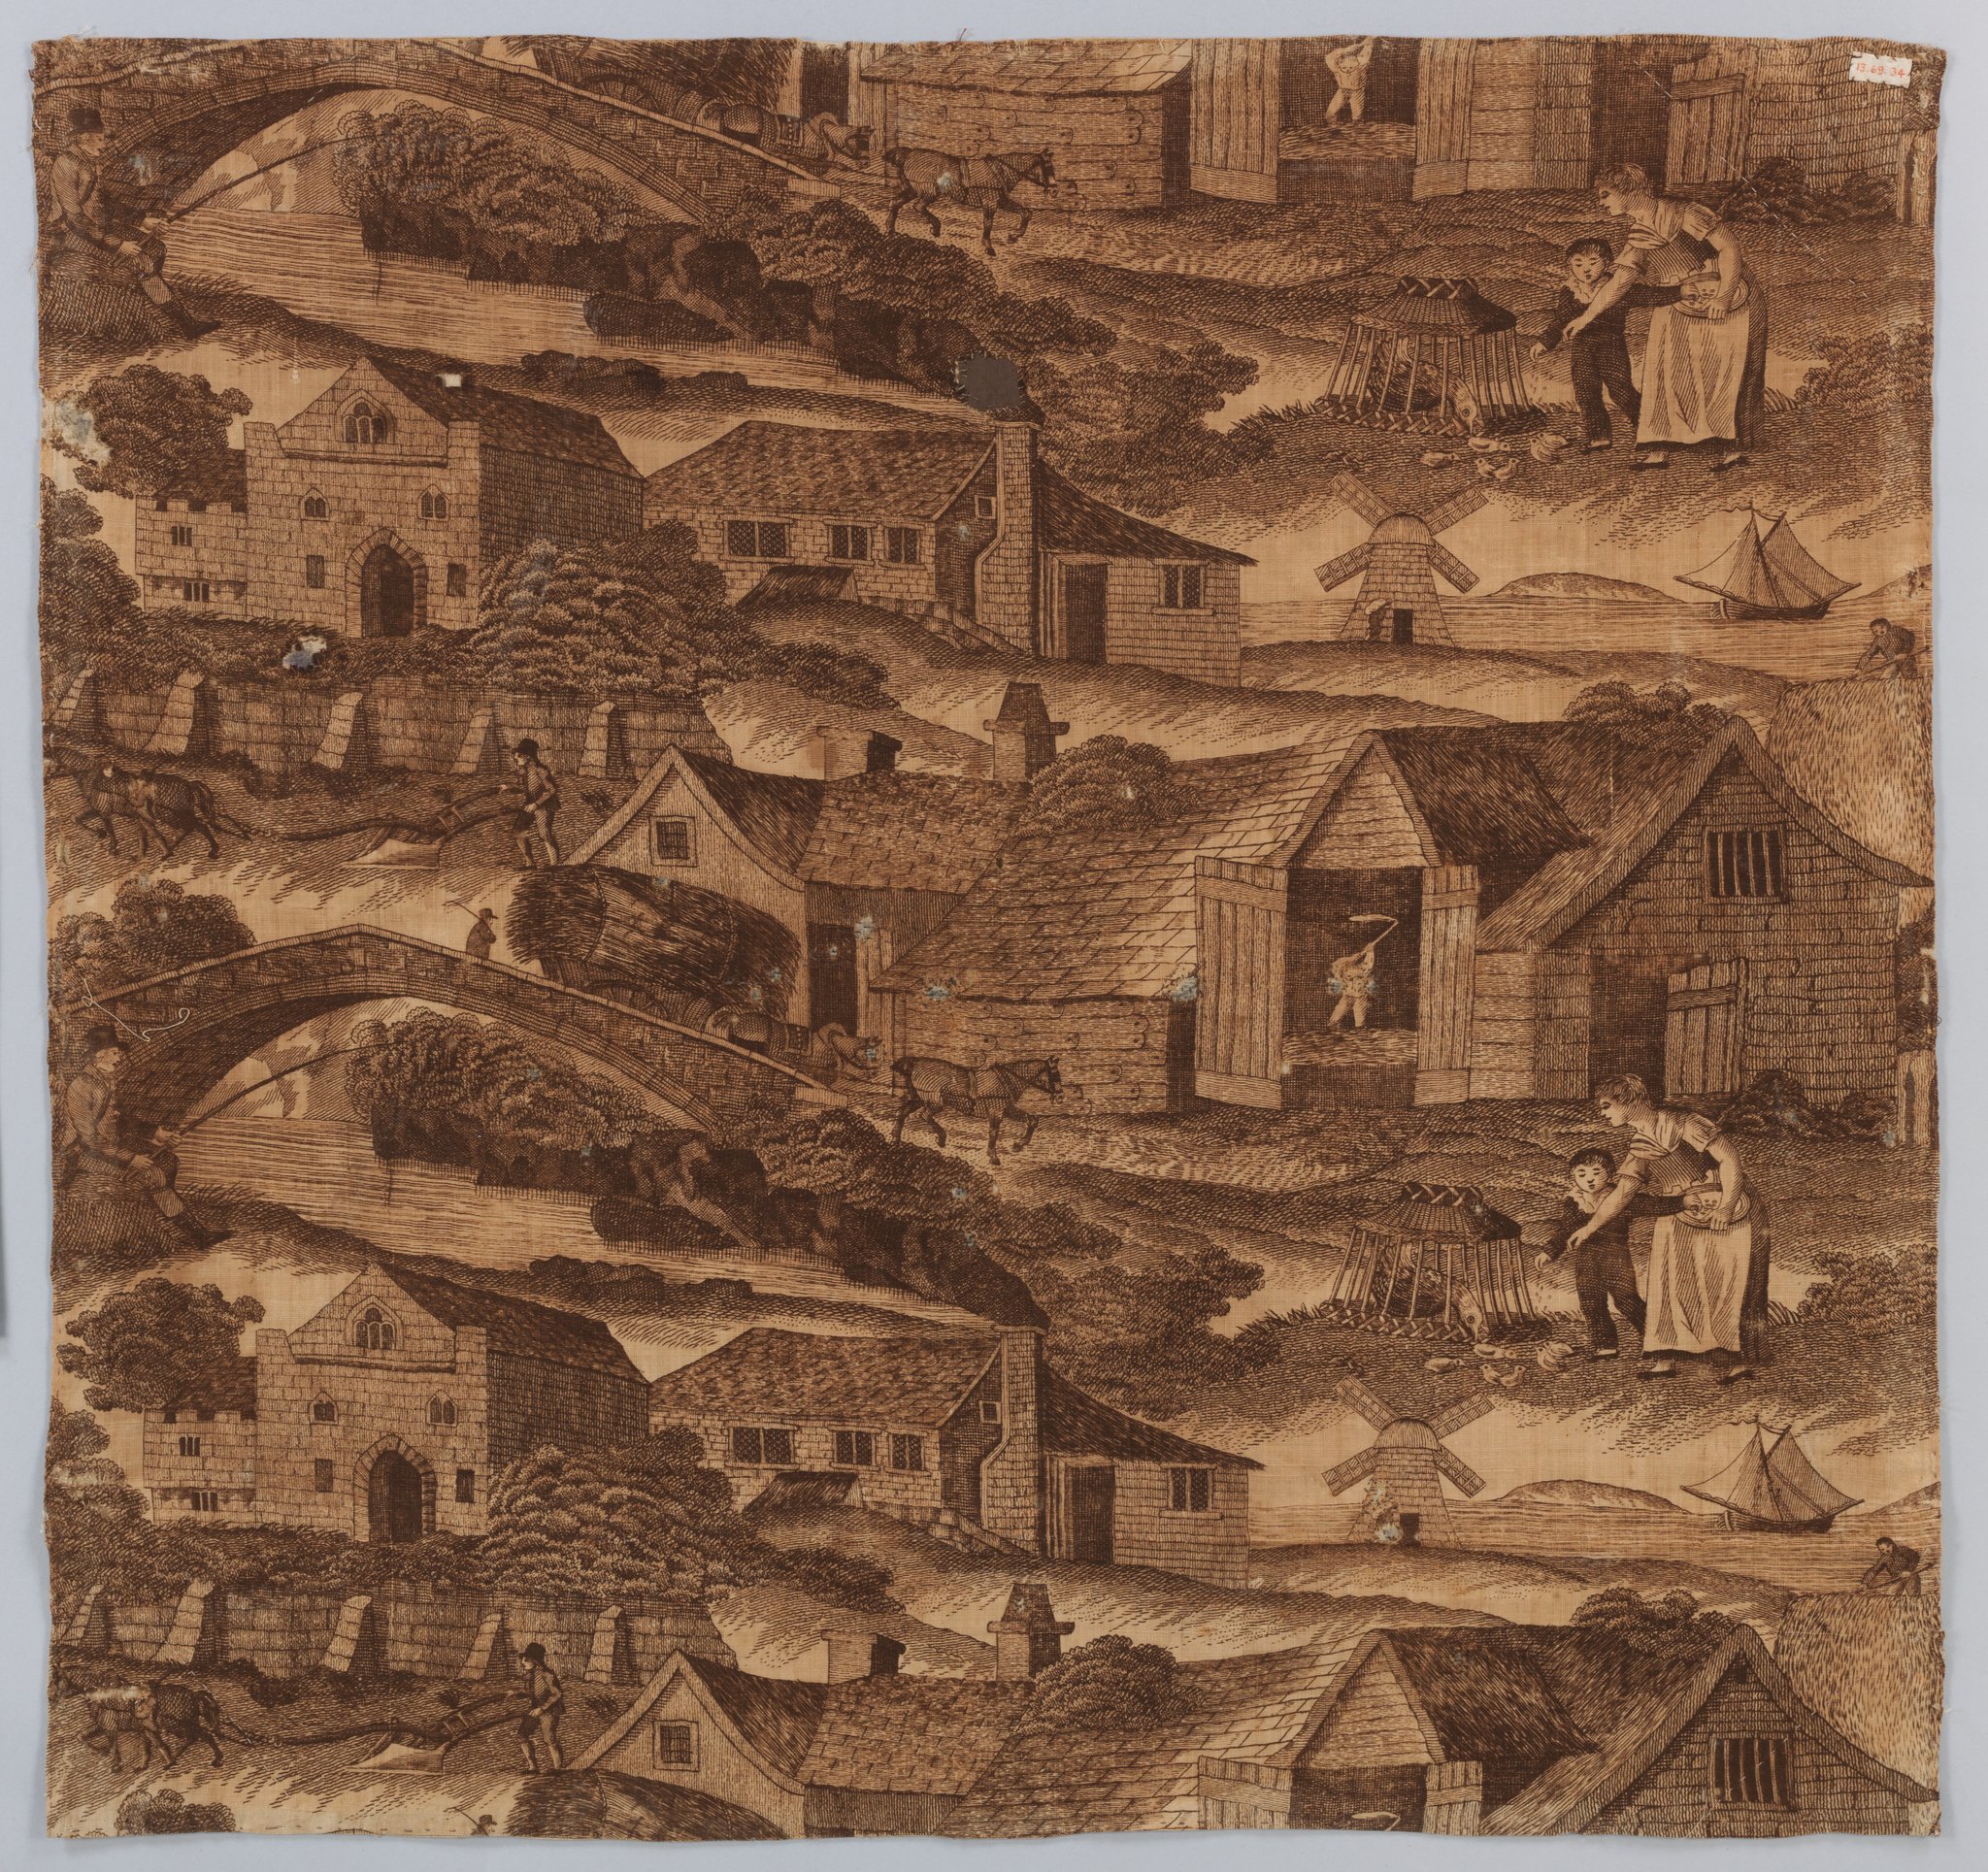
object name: piece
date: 1805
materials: cotton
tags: birds,houses,bridges,women,horses